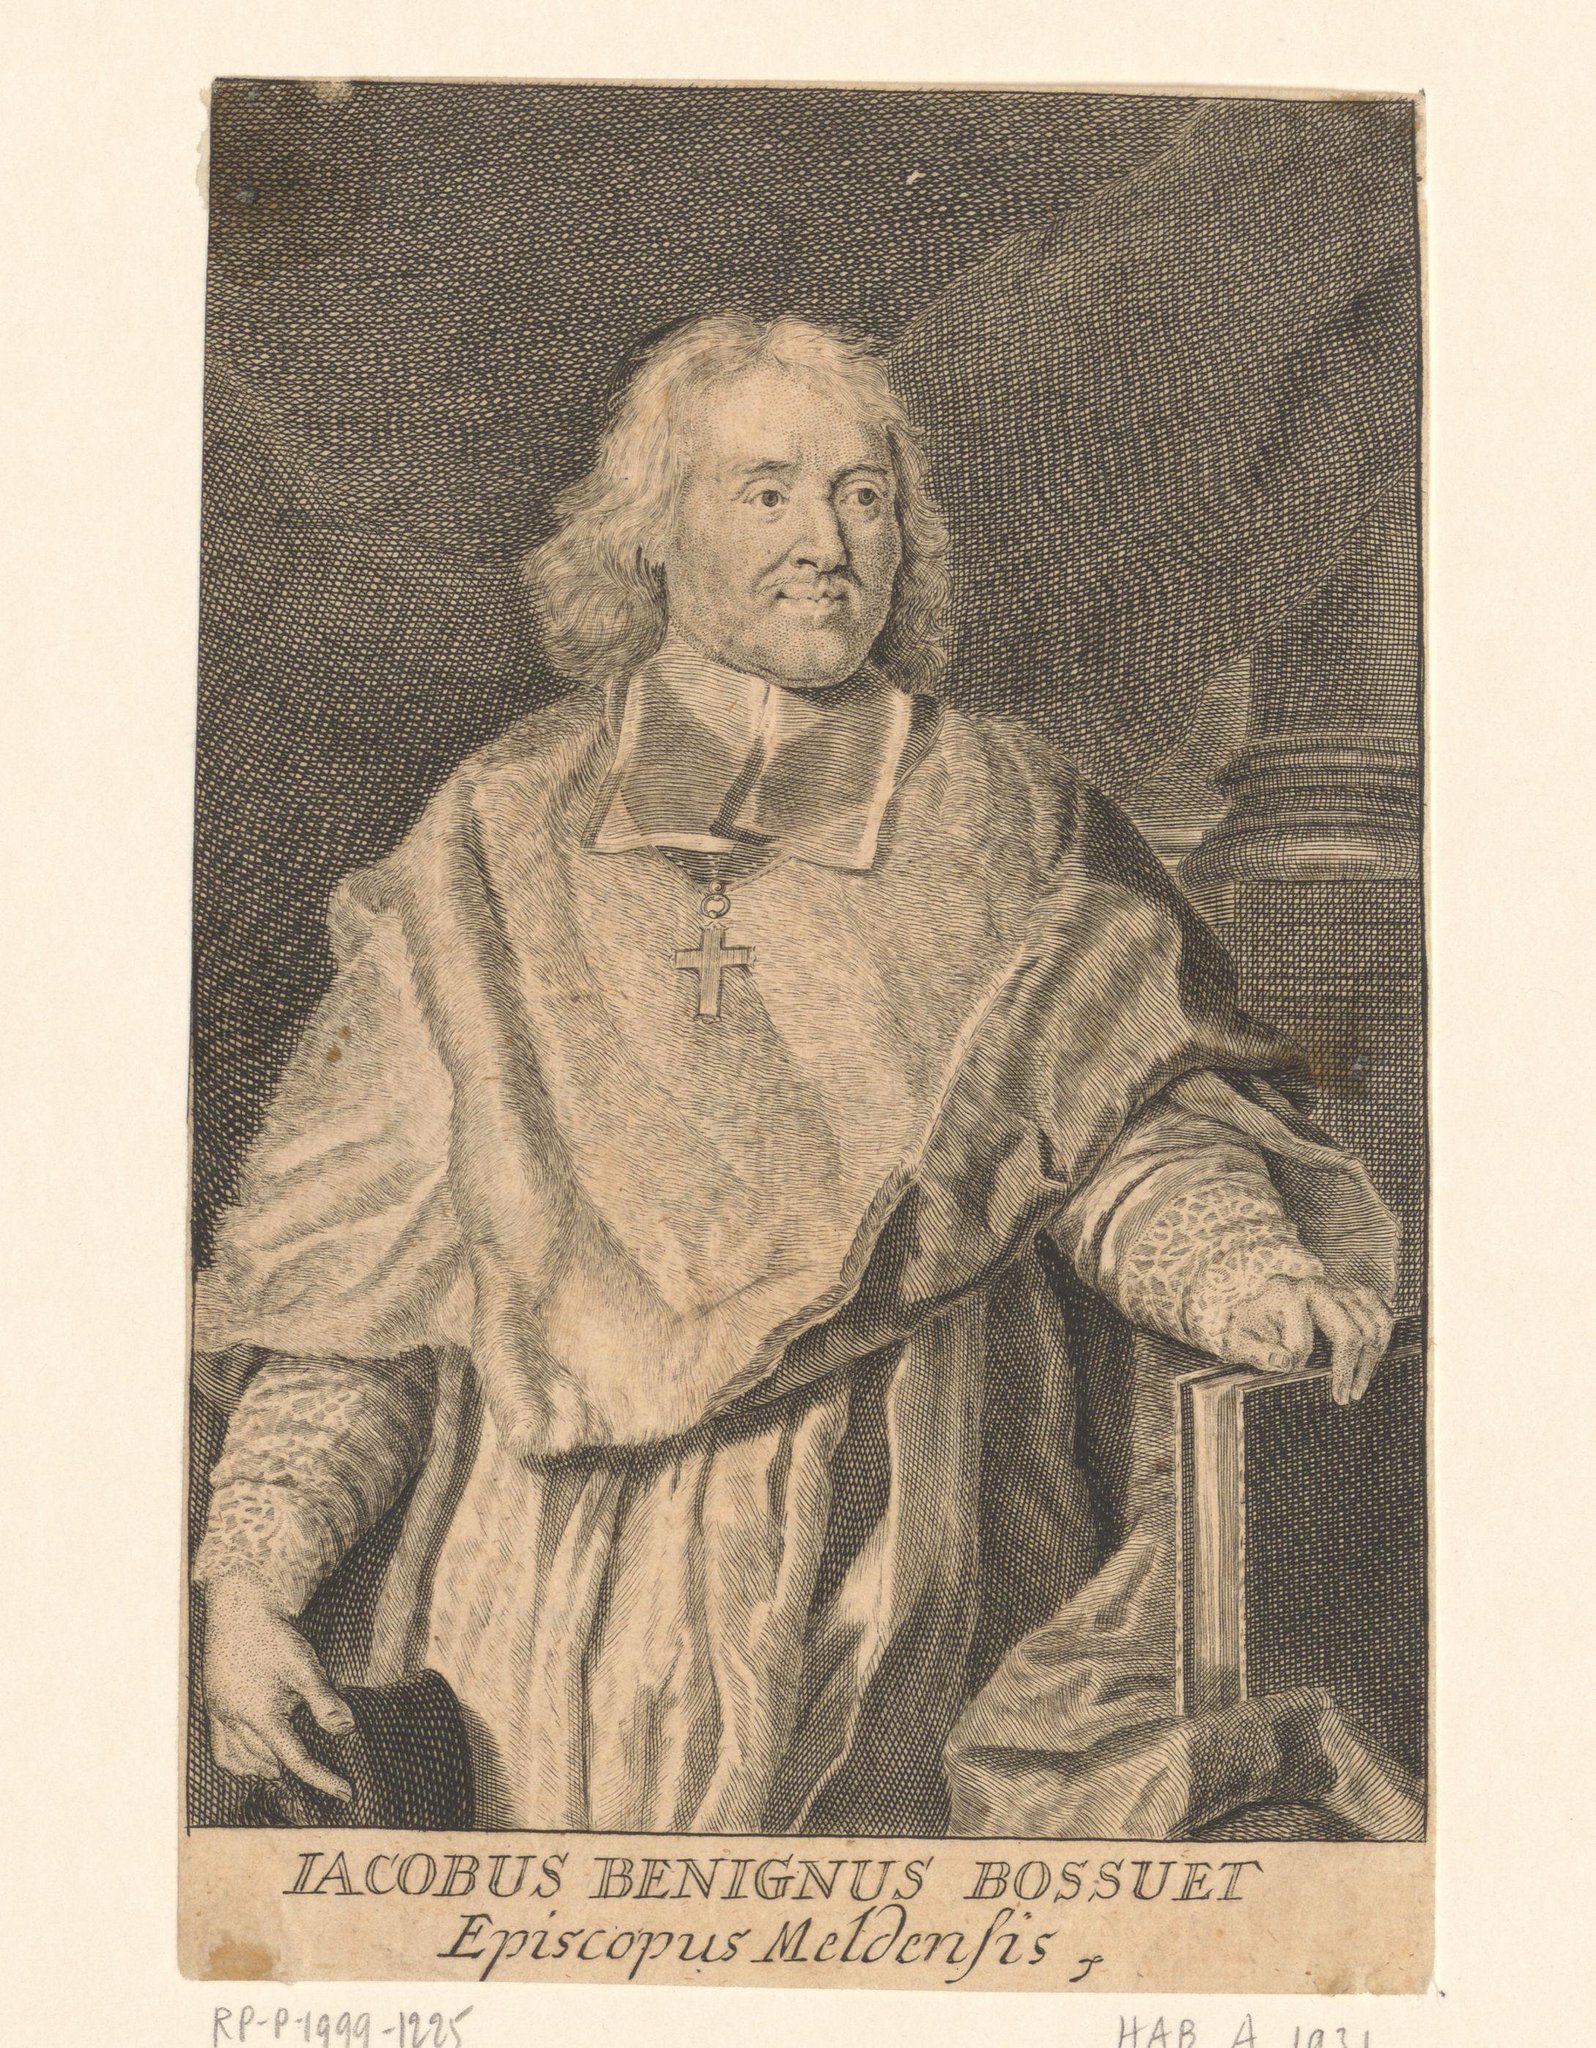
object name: print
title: Portret van Jacques Bénigne Bossuet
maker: martin bernigeroth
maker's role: print maker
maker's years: 1670-1733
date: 1680-1733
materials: paper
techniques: engraving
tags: paris, archbishop, bishop, etc. (roman catholic), historical persons, book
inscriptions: collector's mark: Lugt 2760, collector's mark: Lugt 2228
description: Prent gebruikt in: Deutsche Acta Eruditorum. Leipzig: Johann Gottlieb Gleditsch, 1724, dl. 97.